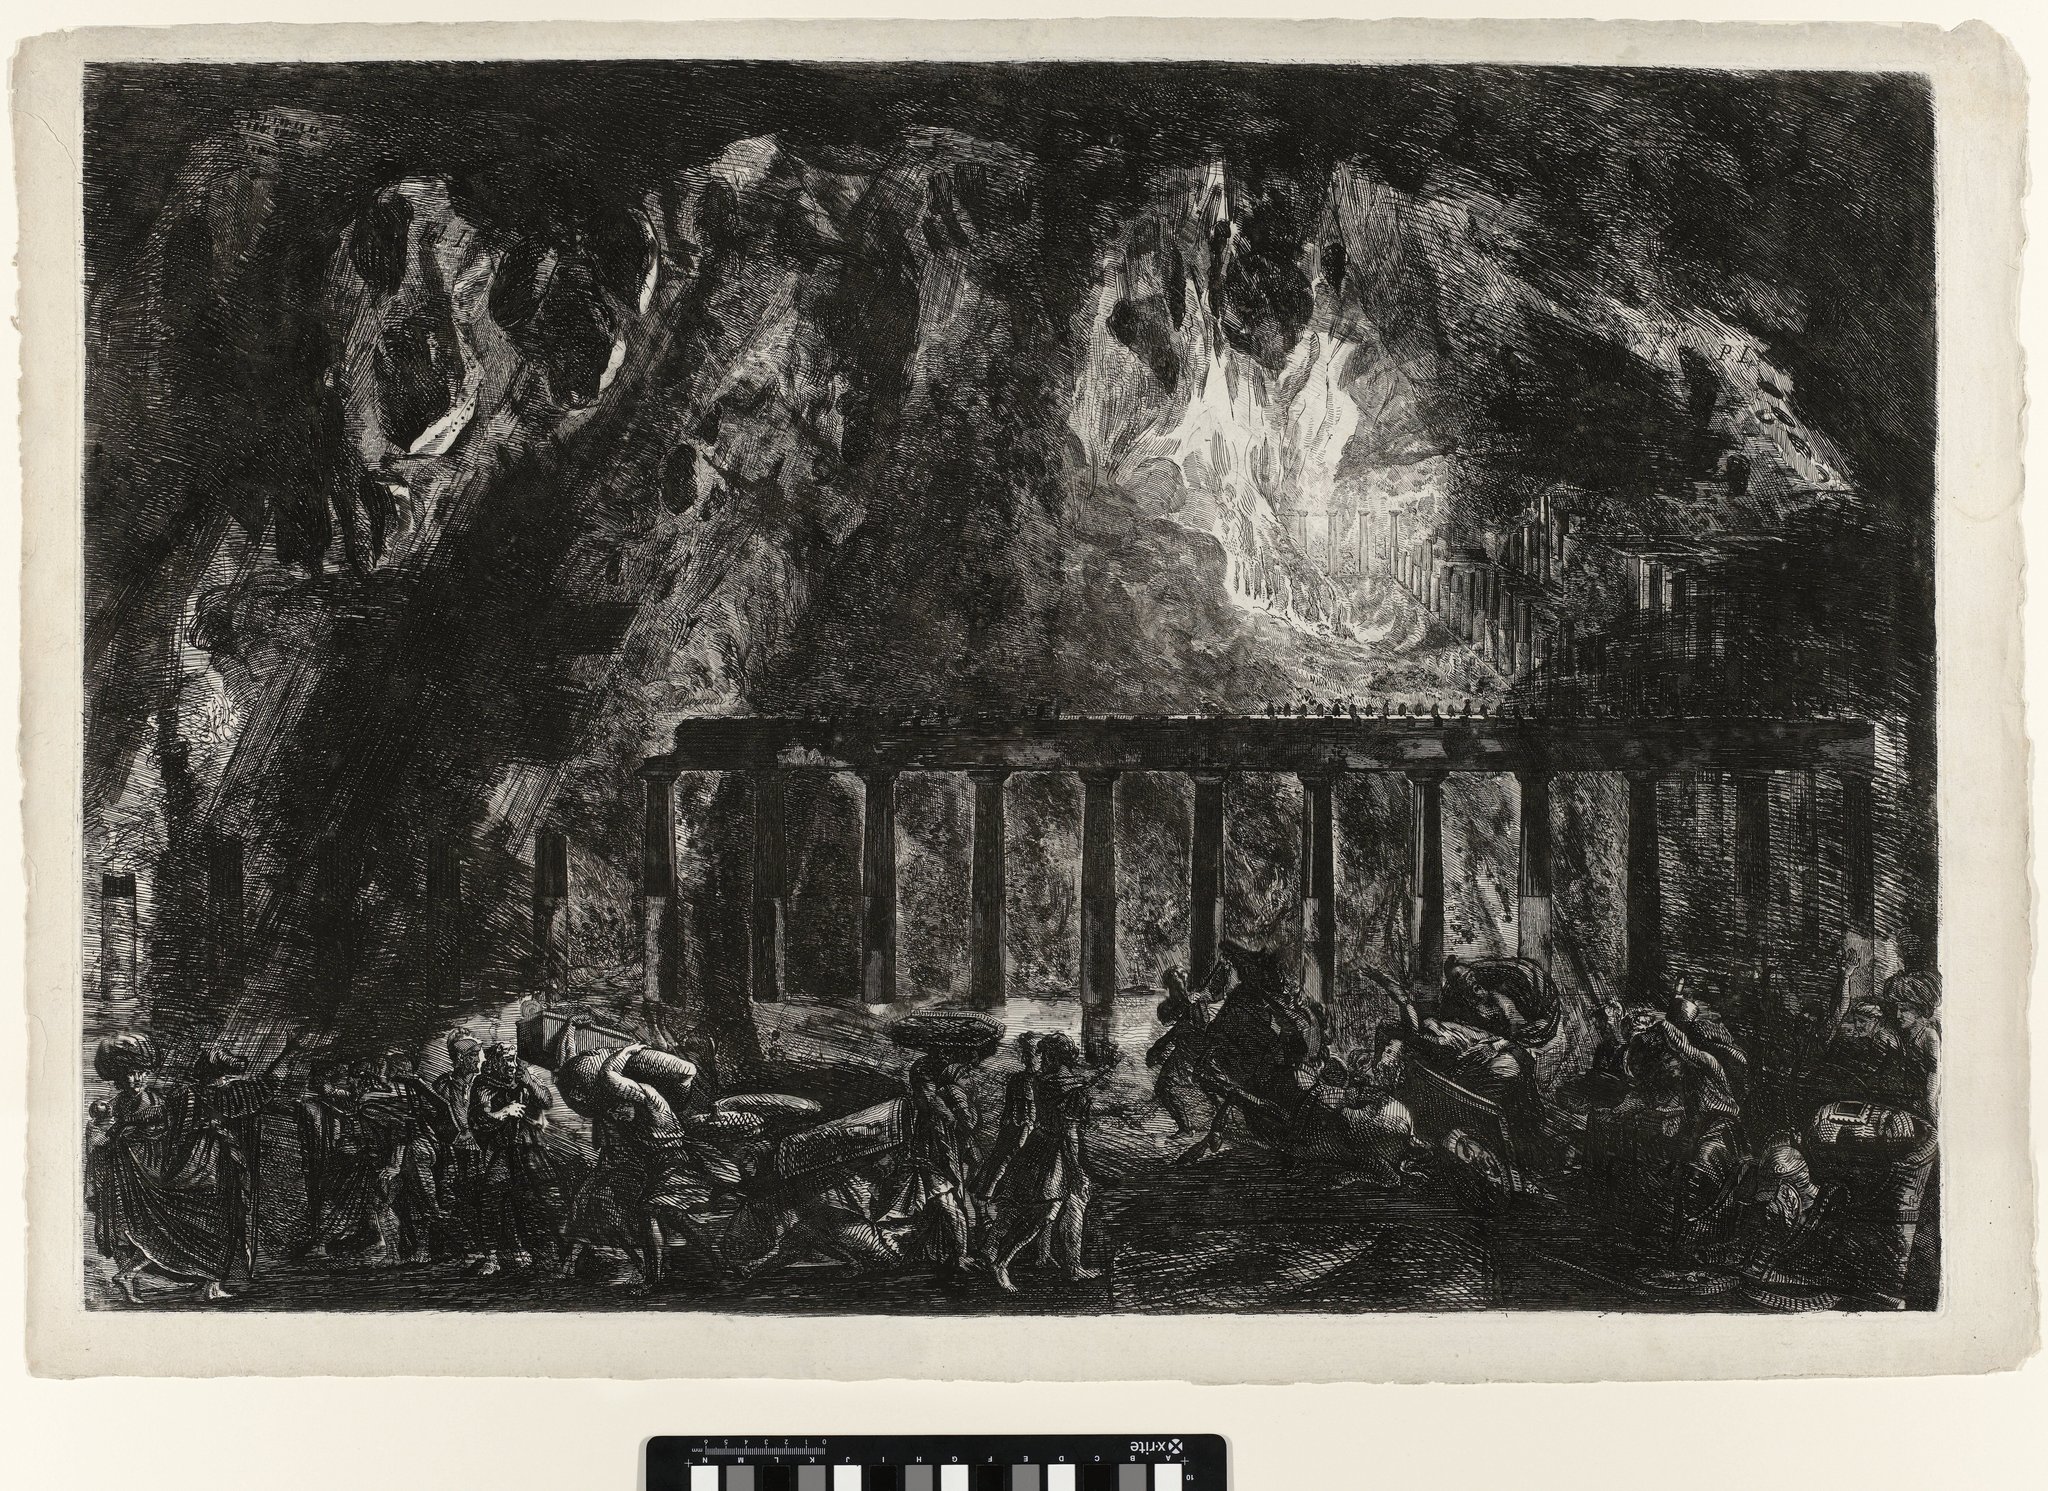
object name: print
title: Ondergang van Pompeï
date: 1797-1817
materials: paper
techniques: etching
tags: eruption (of volcano), pompeii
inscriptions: inscription: ‘P.I.’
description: Een brandende Dorische collonade met daarvoor een grote groep mensen en steigerende paarden. Maakt deel uit van de reeks 'Antiquités de la Grande Grèce'. Ondergang van Pompeï op 24 augustus 79 n.Chr.